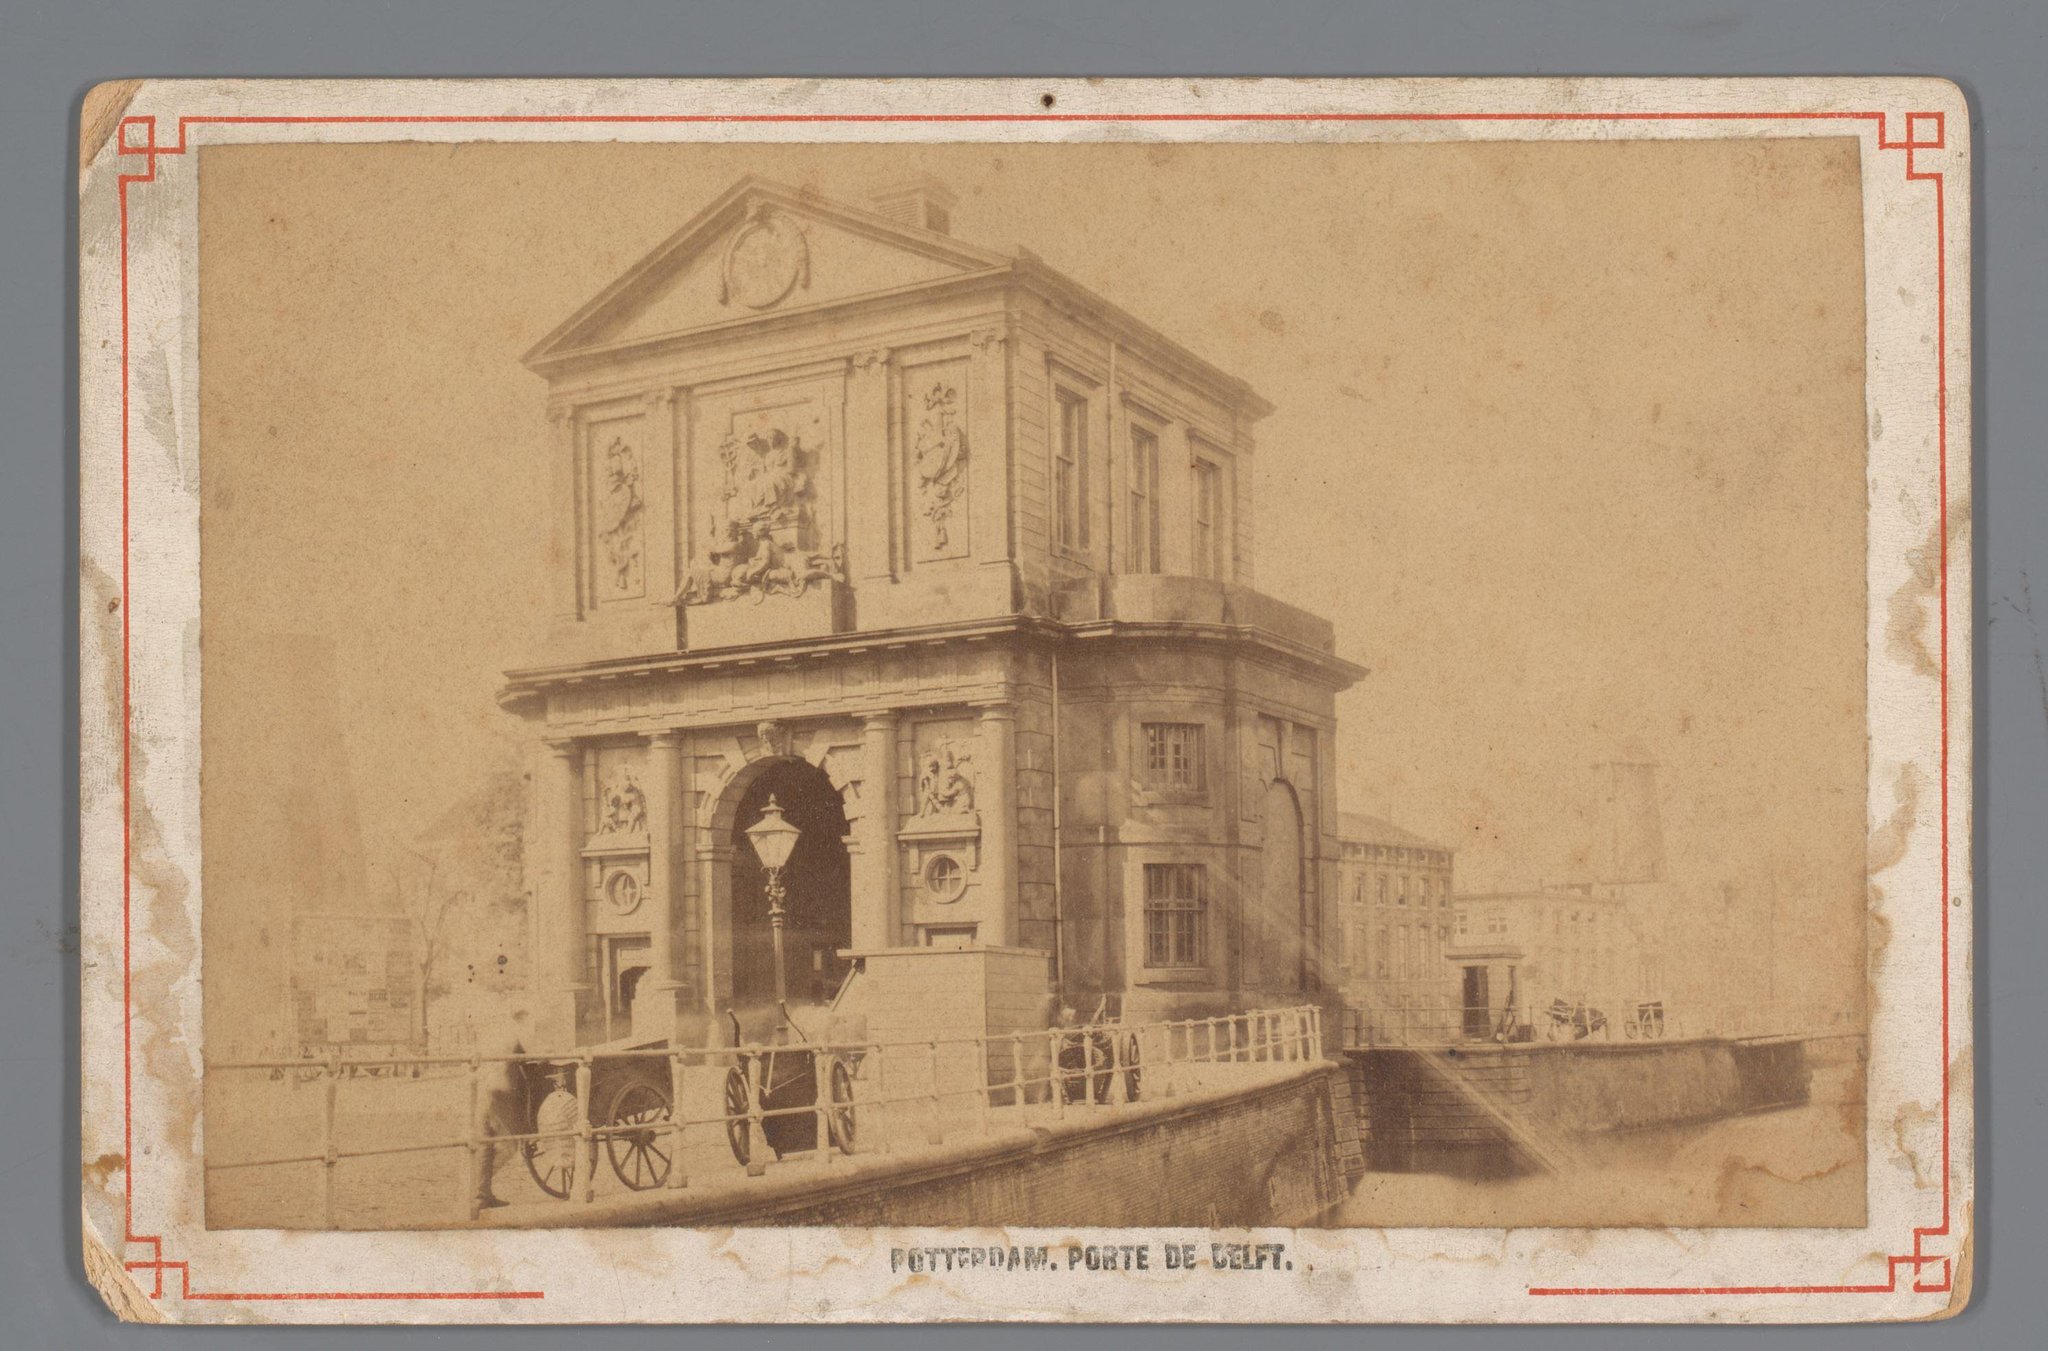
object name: photograph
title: Gezicht op de Delftsche Poort te Rotterdam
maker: Anonymous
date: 1860-1900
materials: cardboard, photographic support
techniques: albumen print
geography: rotterdam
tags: city-gate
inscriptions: inscription: ‘Rotterdam. Porte de Delft’